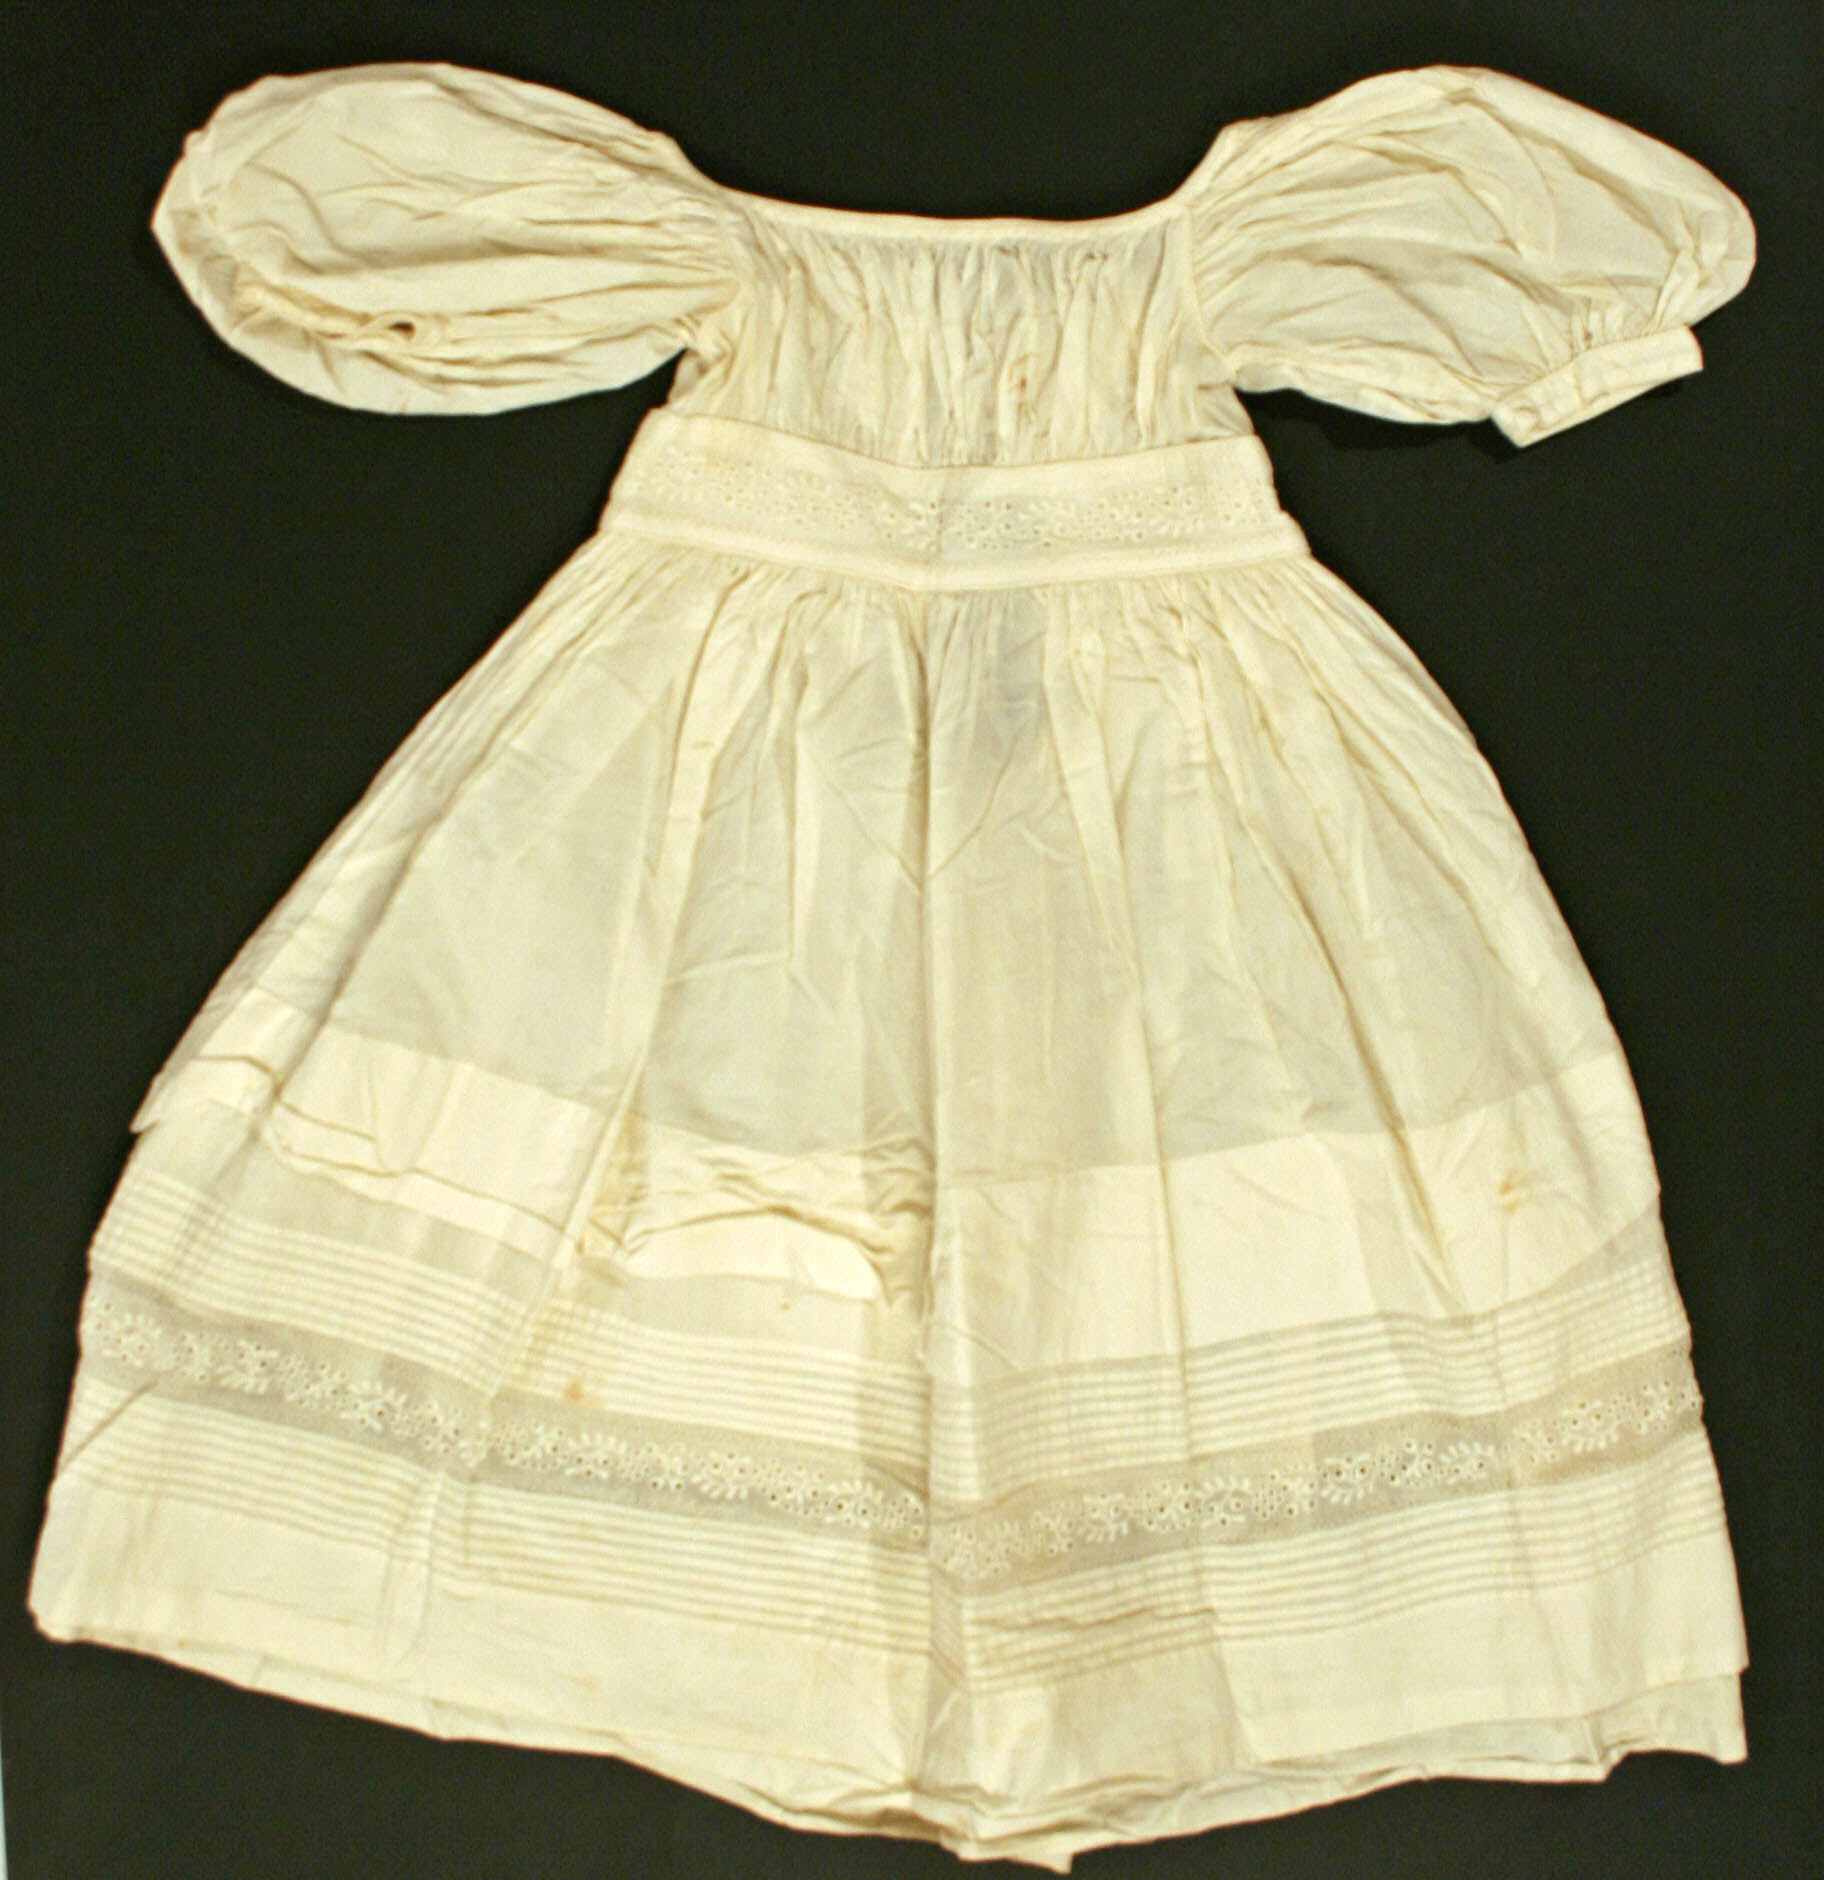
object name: dress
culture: american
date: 1825-1829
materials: cotton